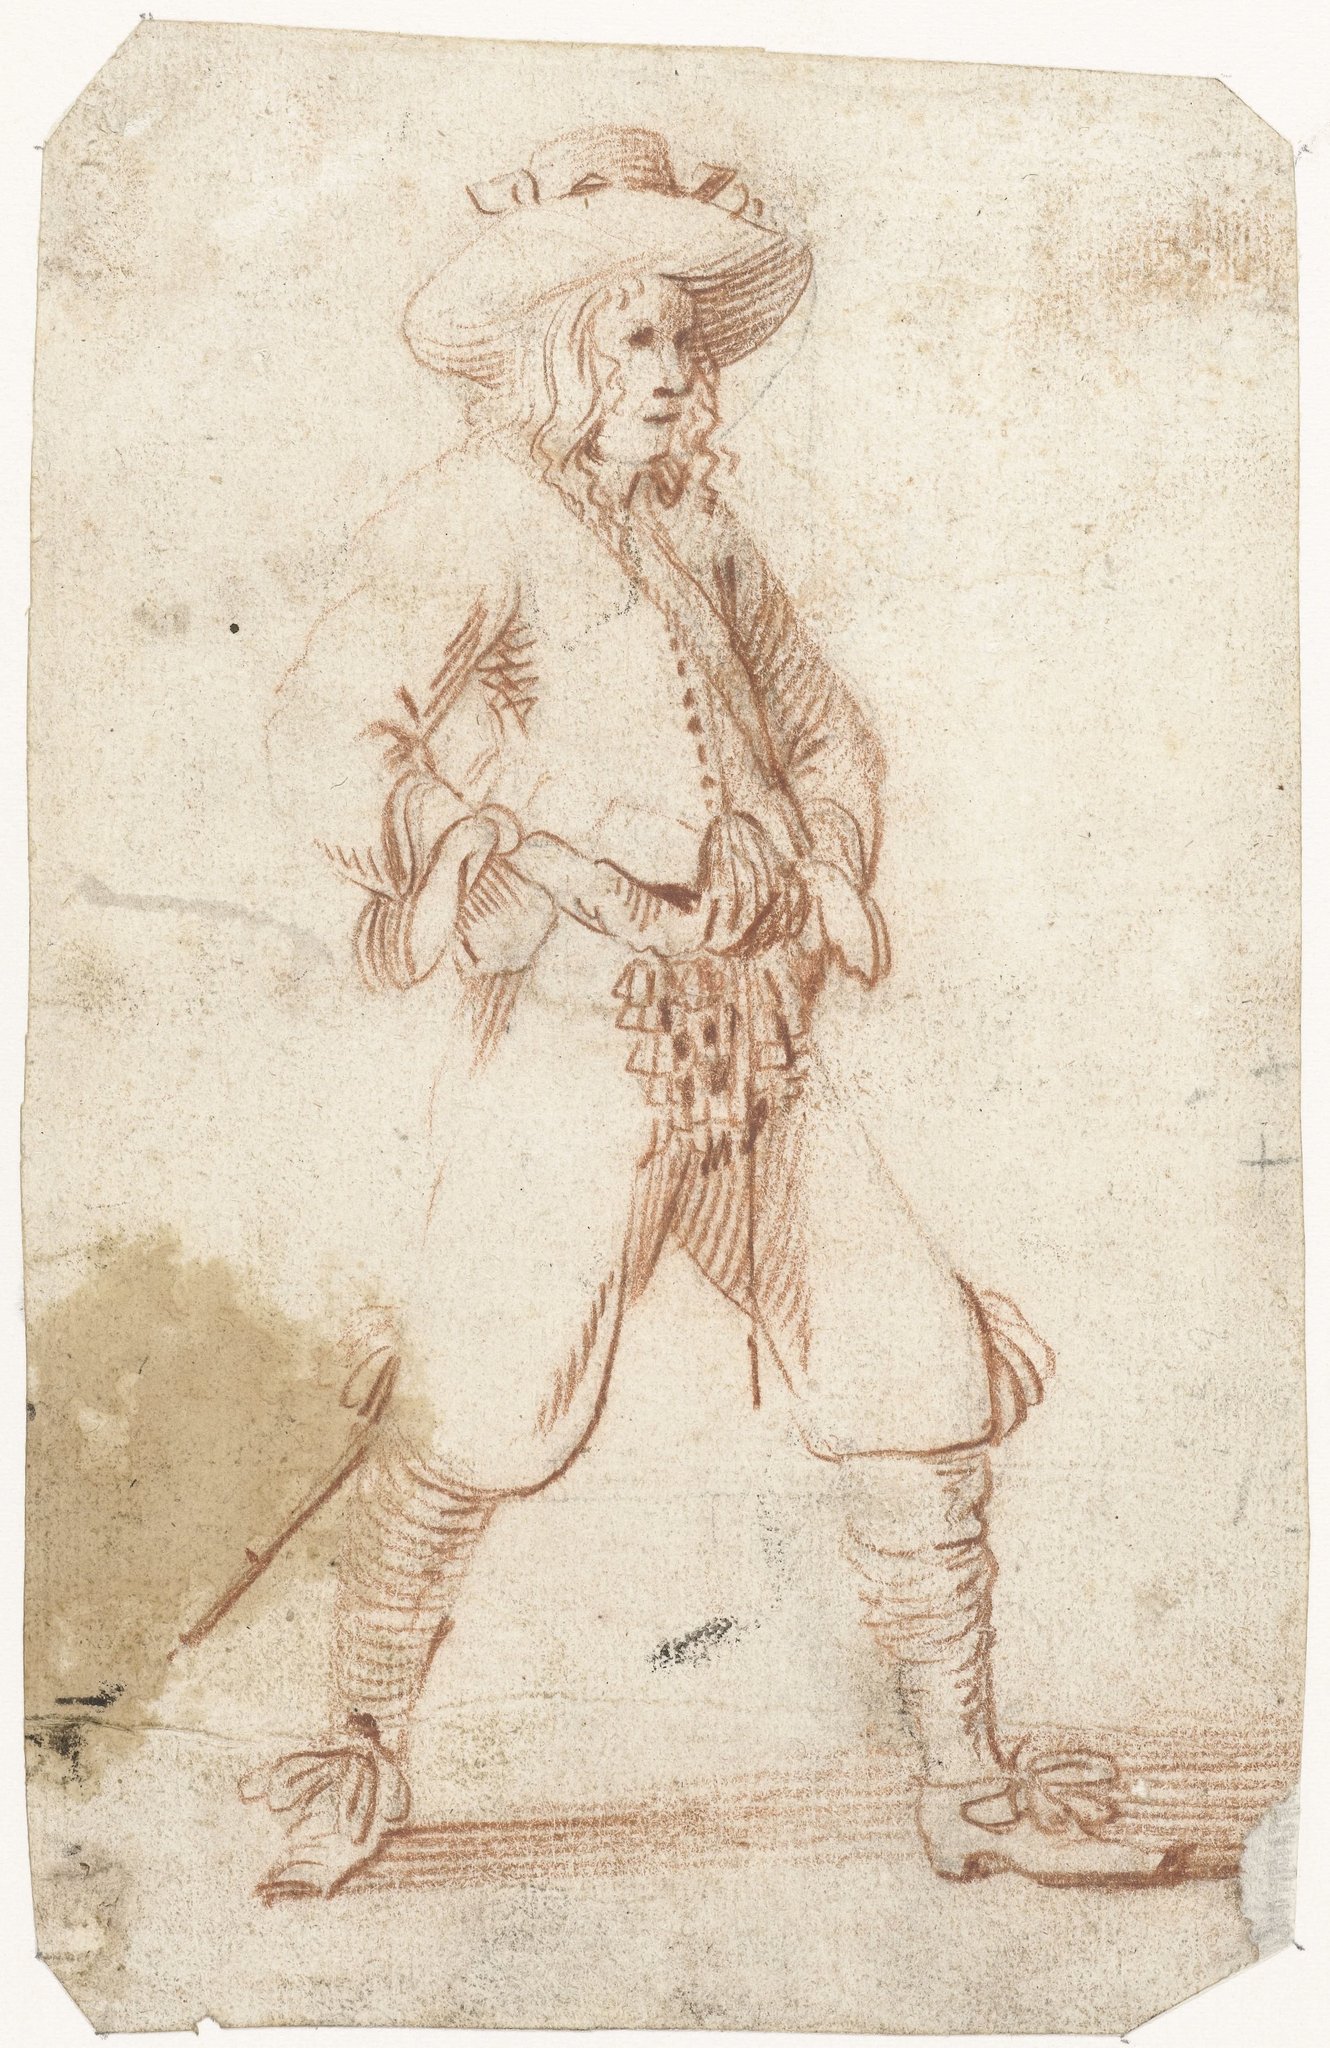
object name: drawing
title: Heer staand met zijn handen in zijn zij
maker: gesina ter borch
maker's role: draughtsman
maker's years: 1633-1690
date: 1660-1669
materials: chalk, paper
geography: zwolle